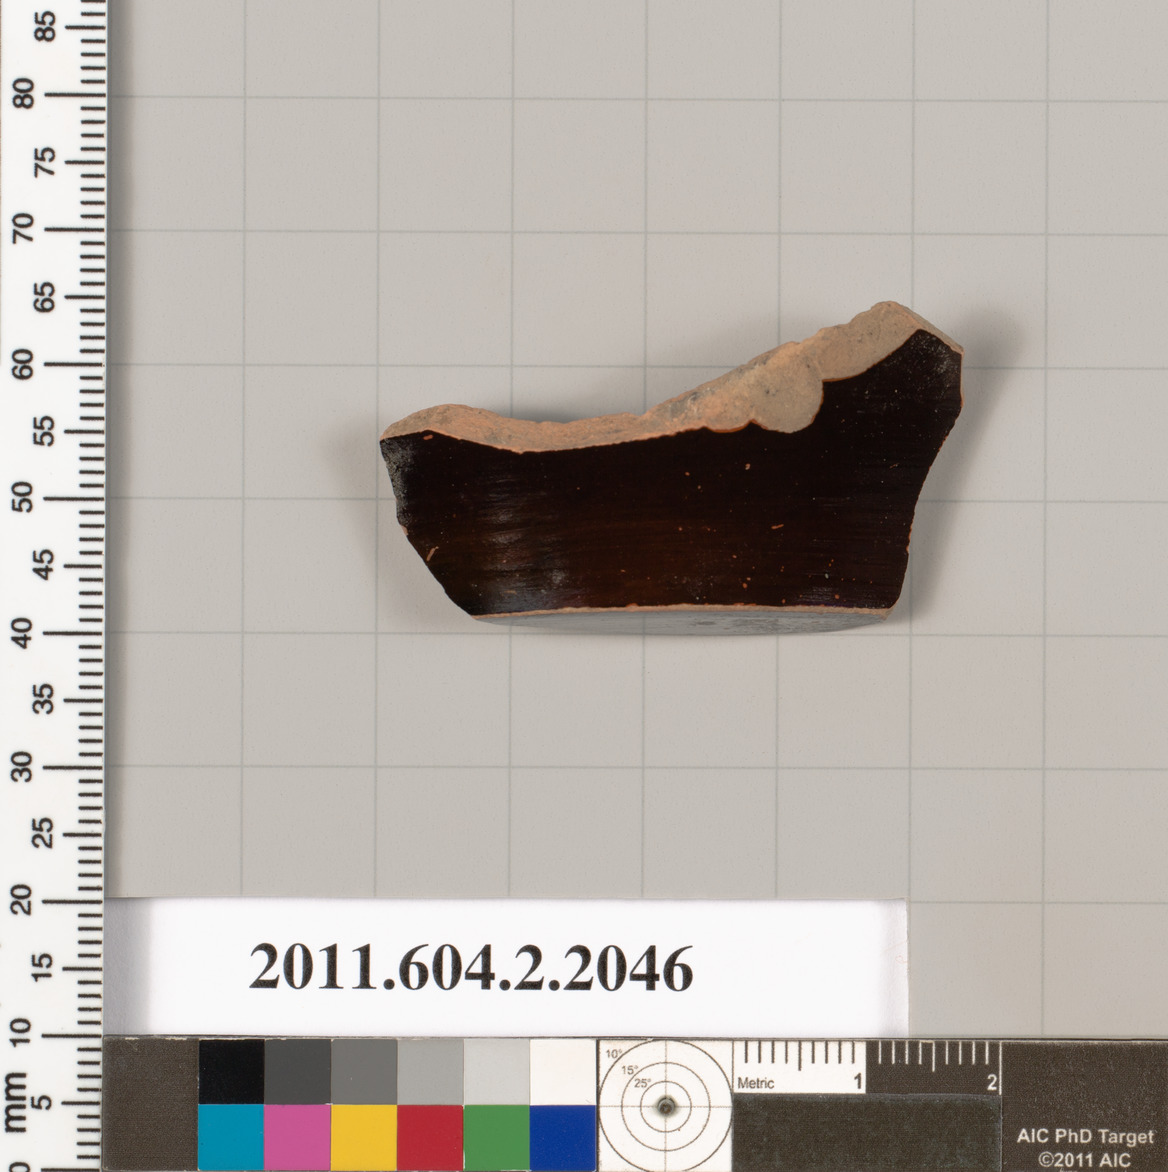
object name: kalathos fragment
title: Terracotta fragment of a kalathos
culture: greek, attic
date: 520-500 BCE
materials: terracotta